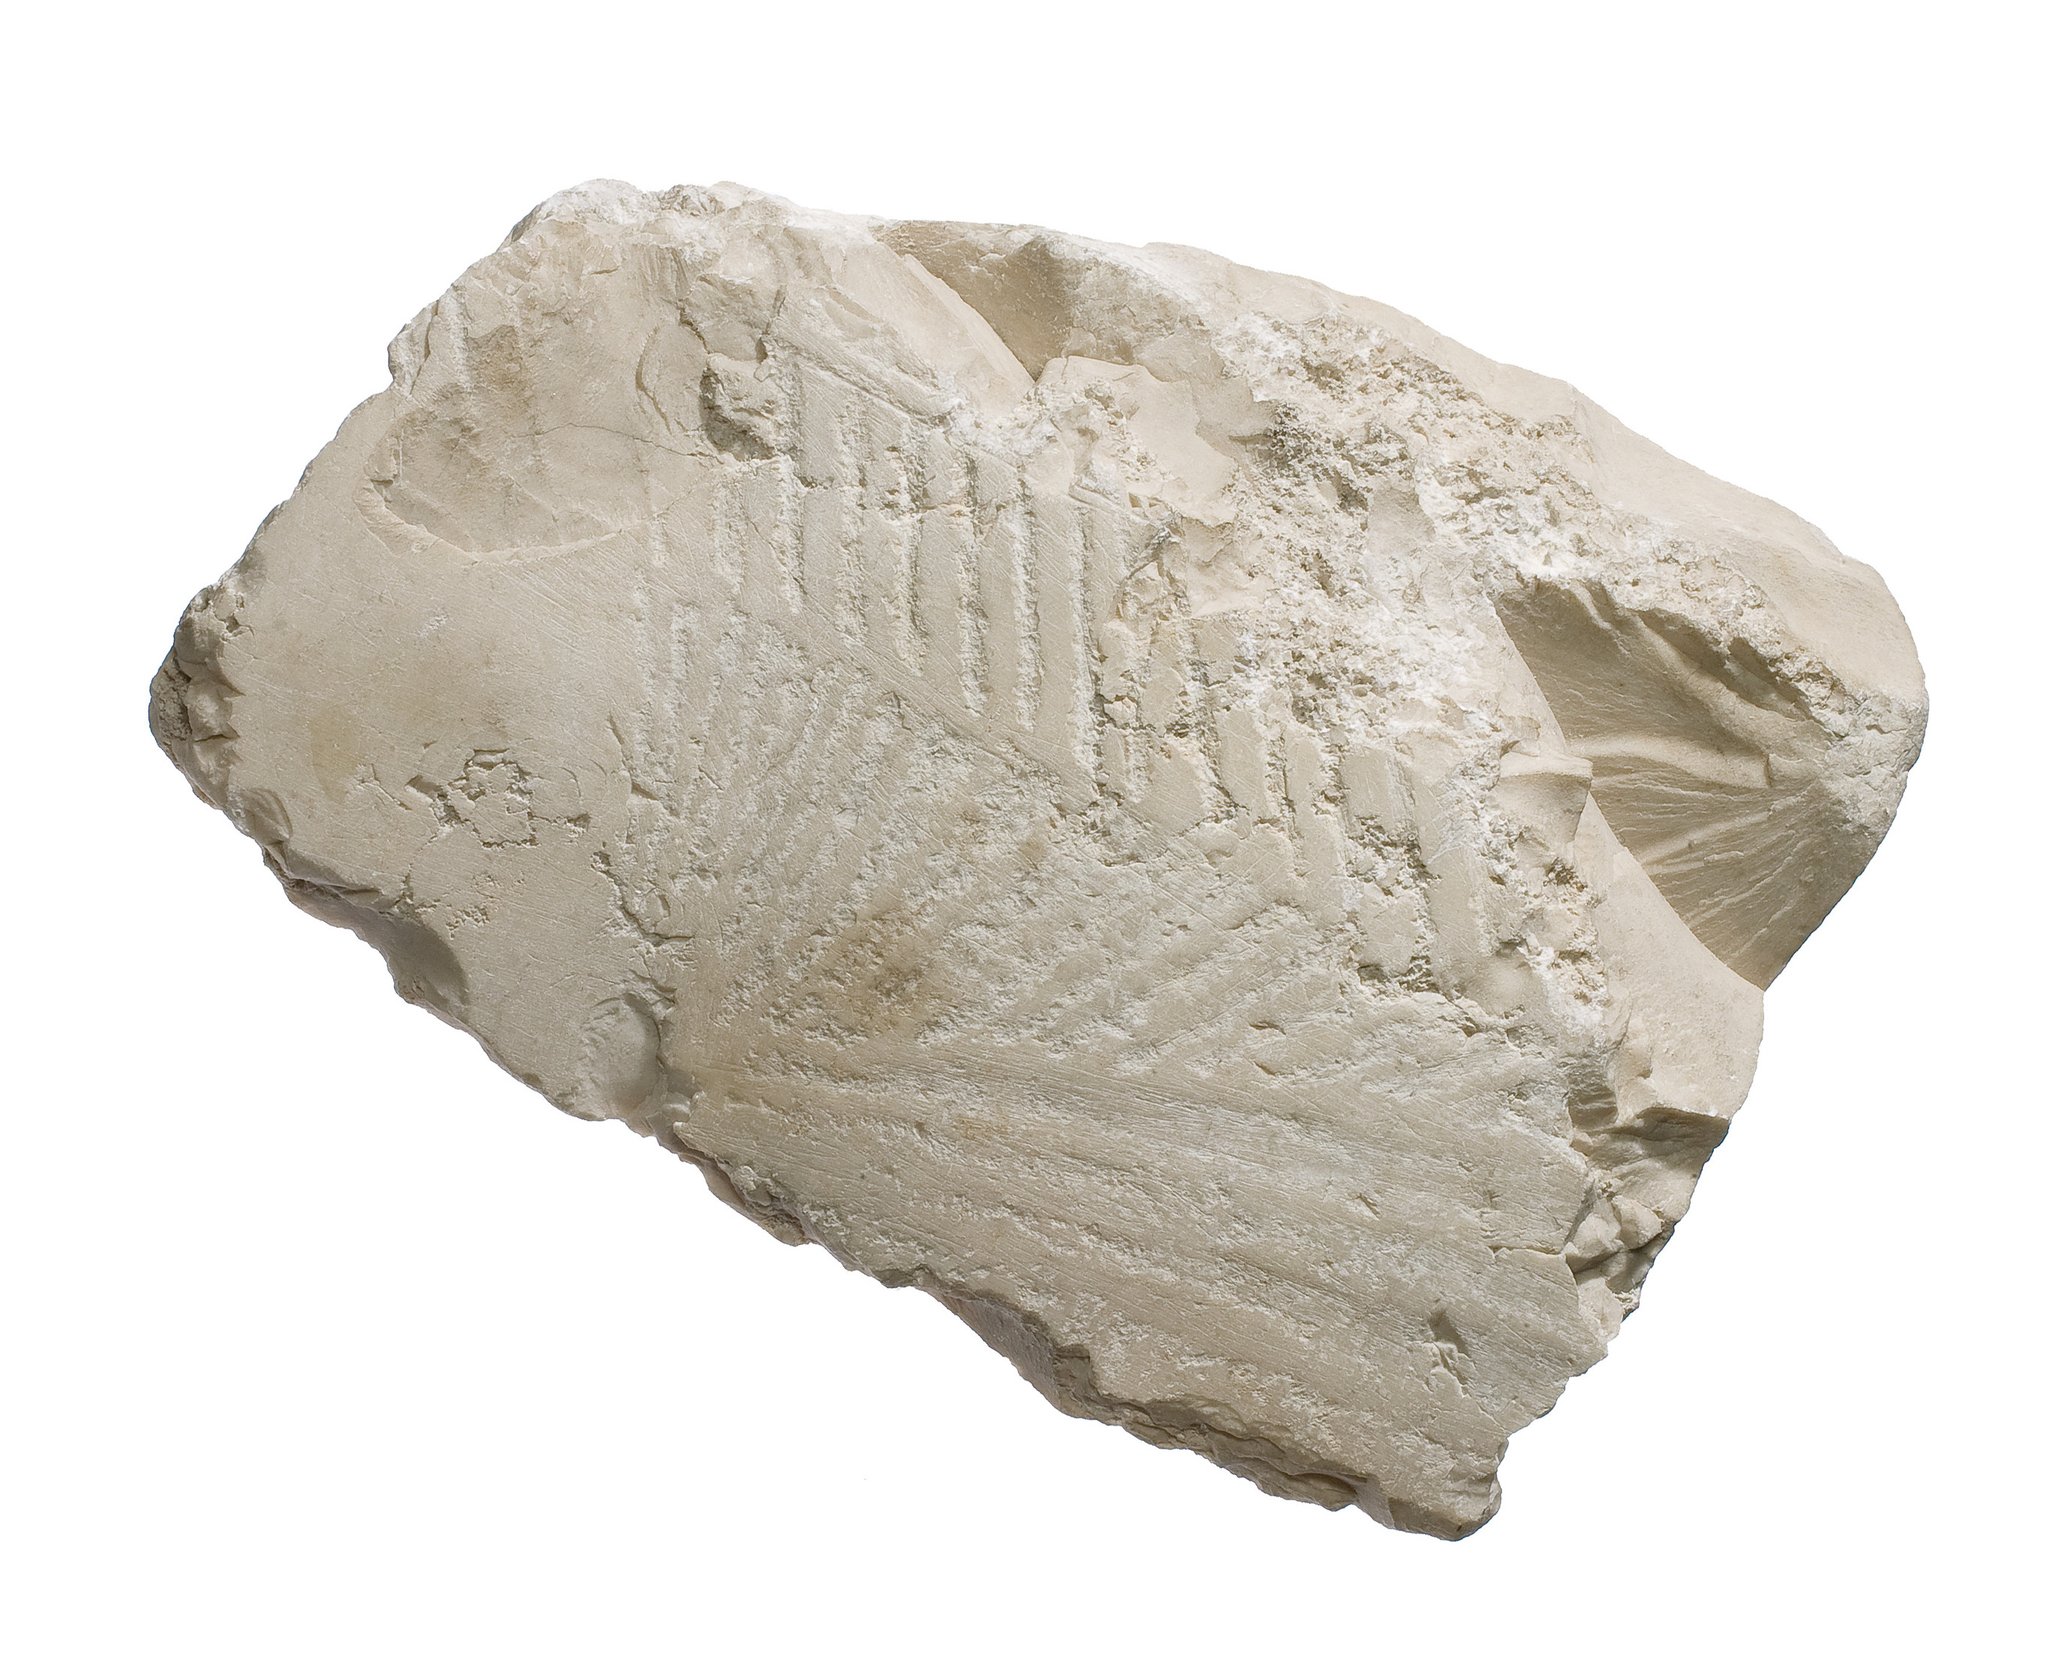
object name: breast garment fringe, pleating relief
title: Breast (?) with pleating and shawl fringe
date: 1353-1336 BCE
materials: limestone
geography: egypt